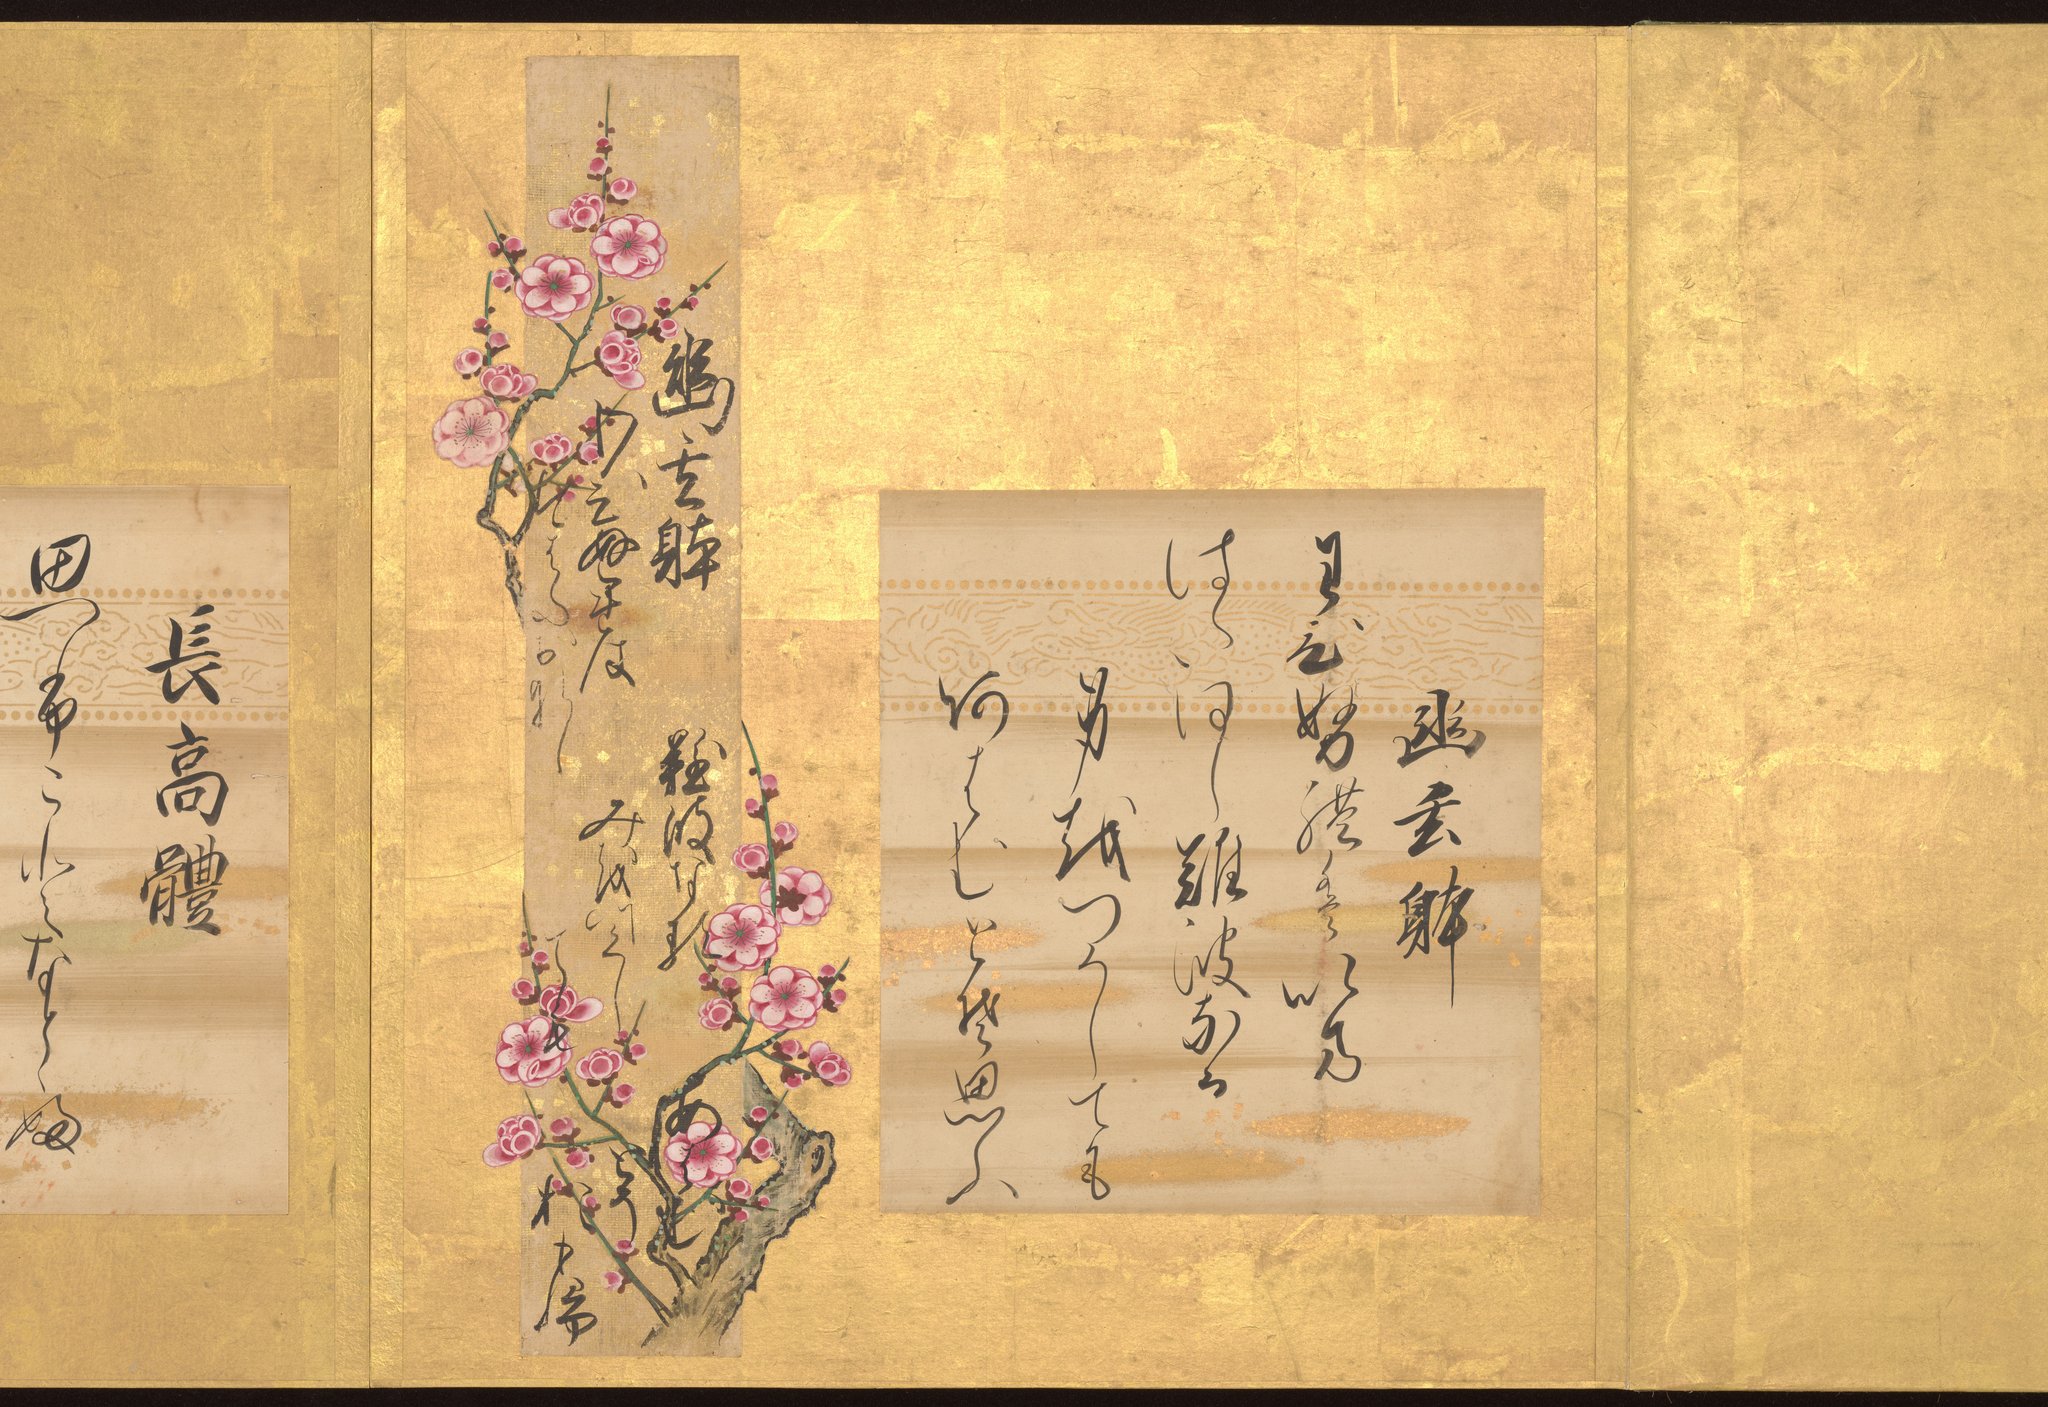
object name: album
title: Teika’s Ten Styles of Japanese Poetry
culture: japanese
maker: unidentified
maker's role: artist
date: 1701-1733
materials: ink, paper